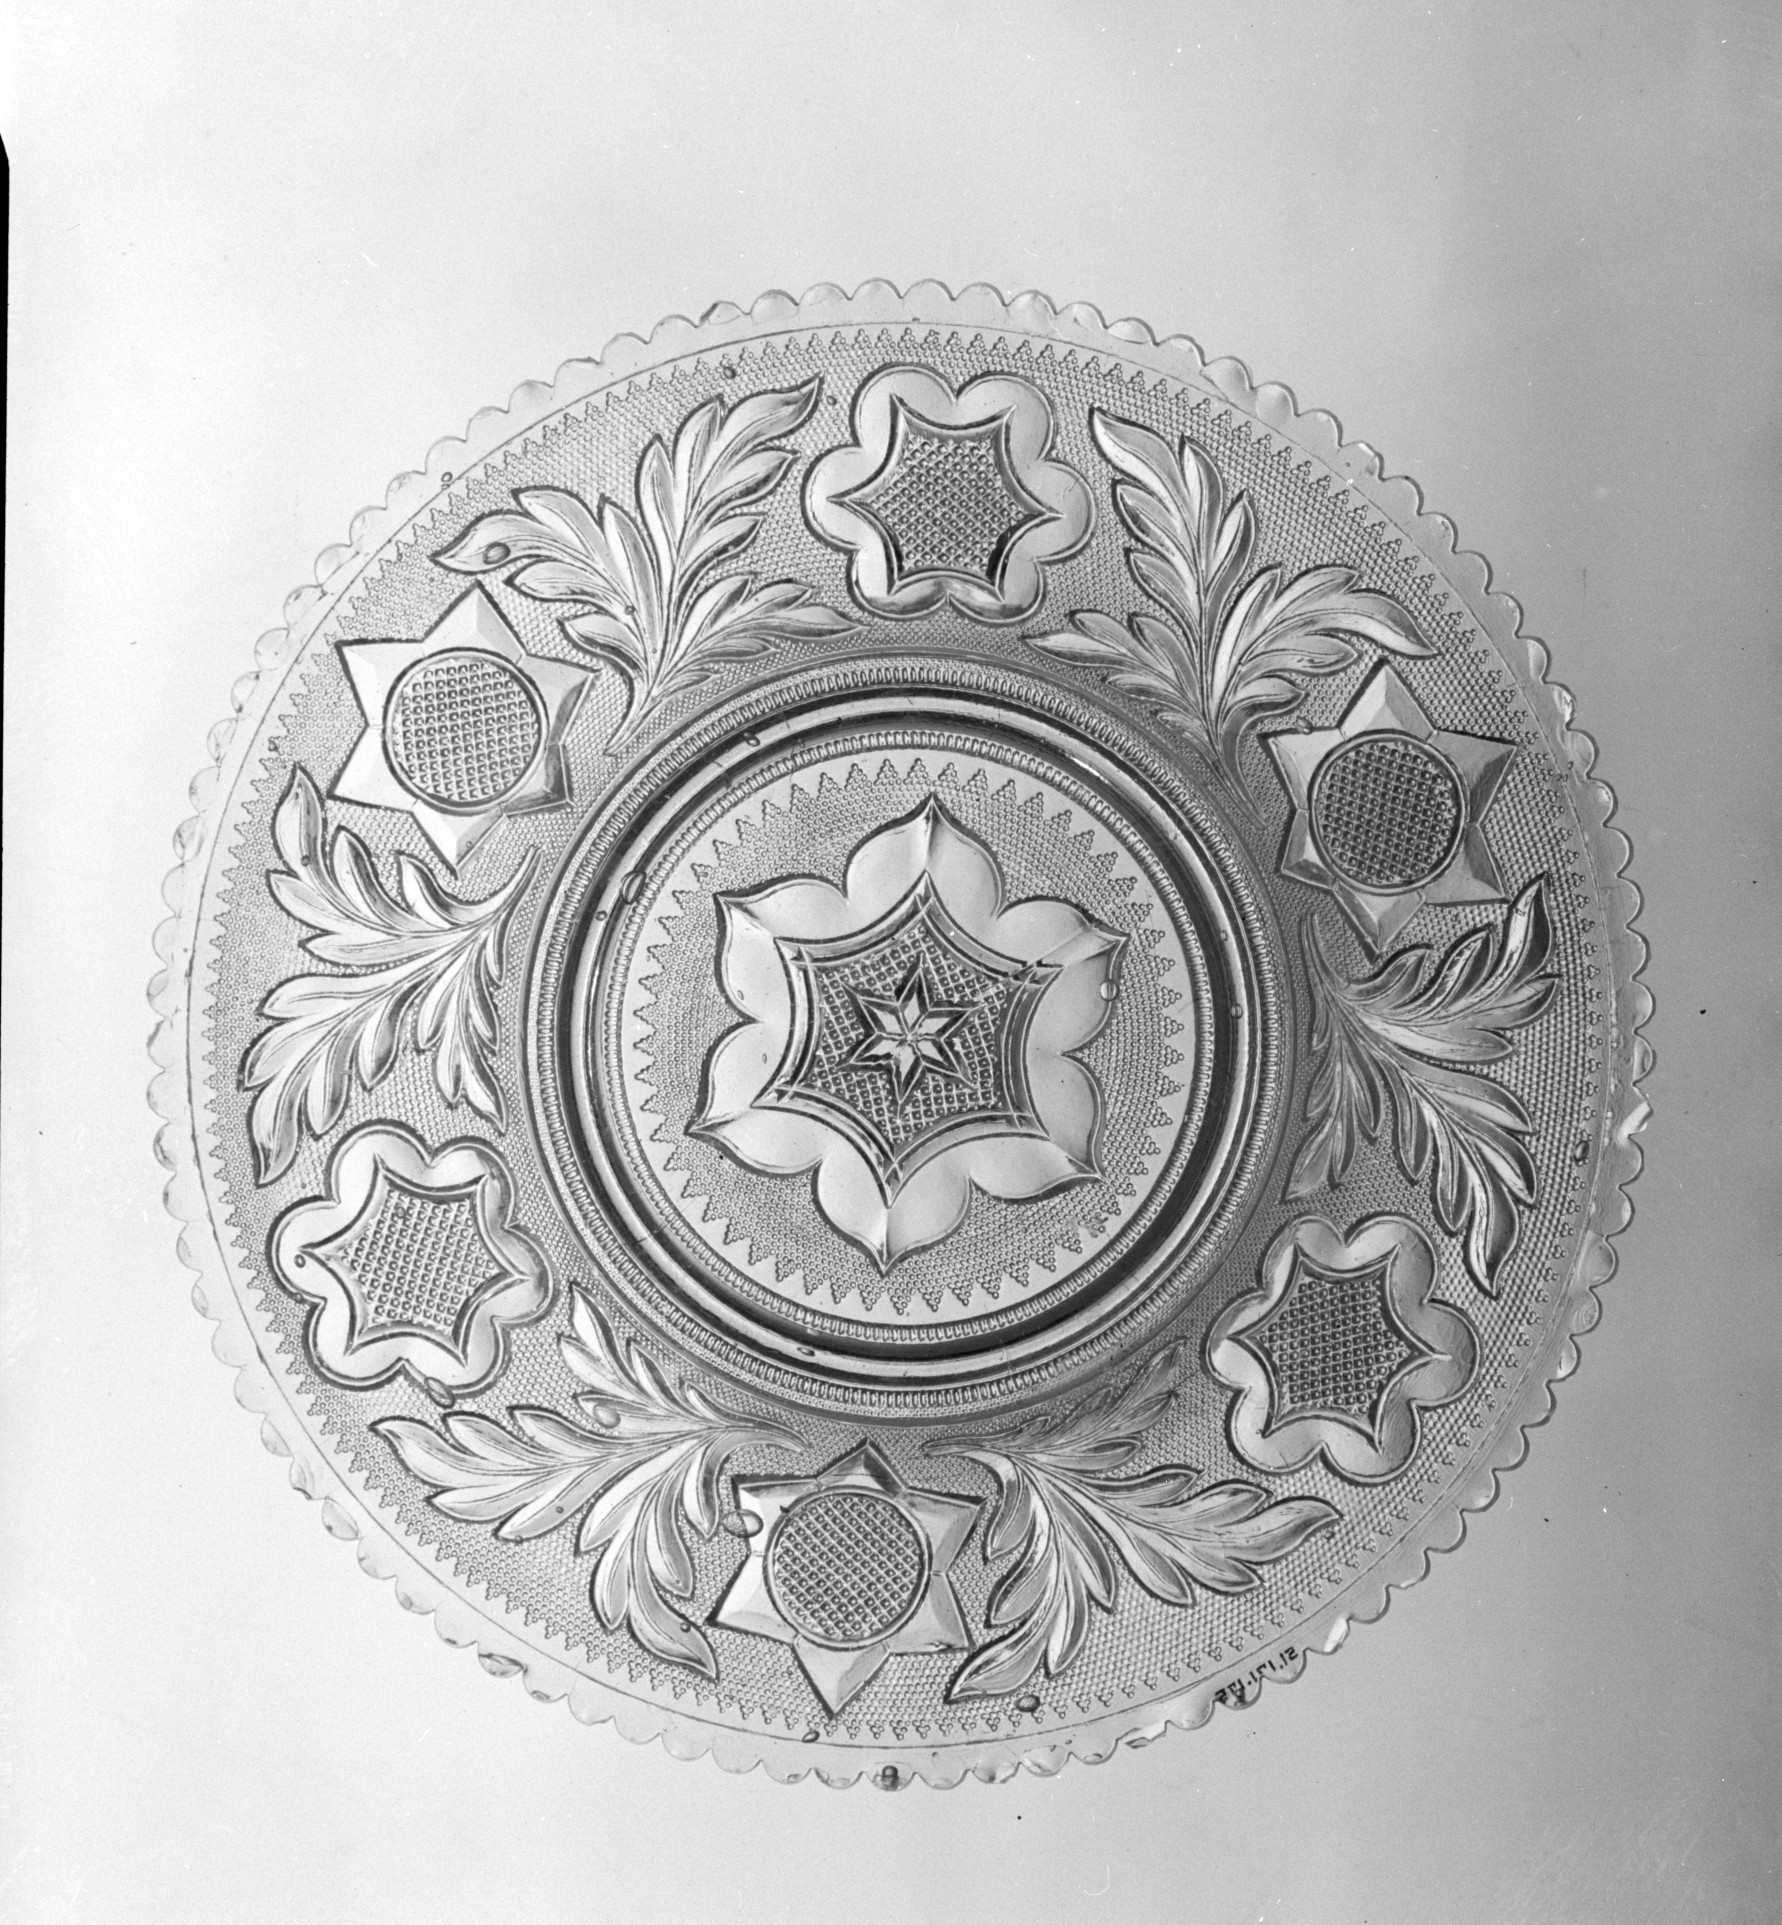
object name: bowl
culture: american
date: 1835-1850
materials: glass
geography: united states